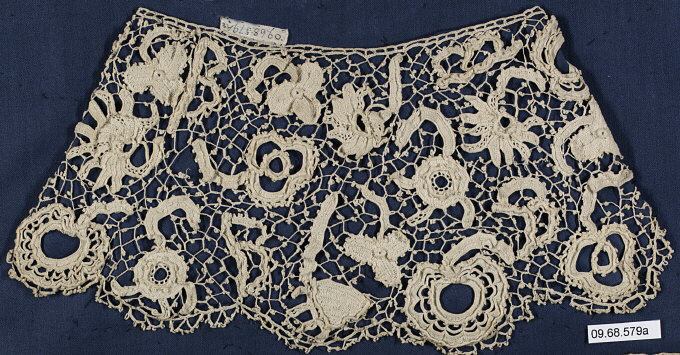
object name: cuff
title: Cuff (one of a pair)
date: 1901-2000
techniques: crochet